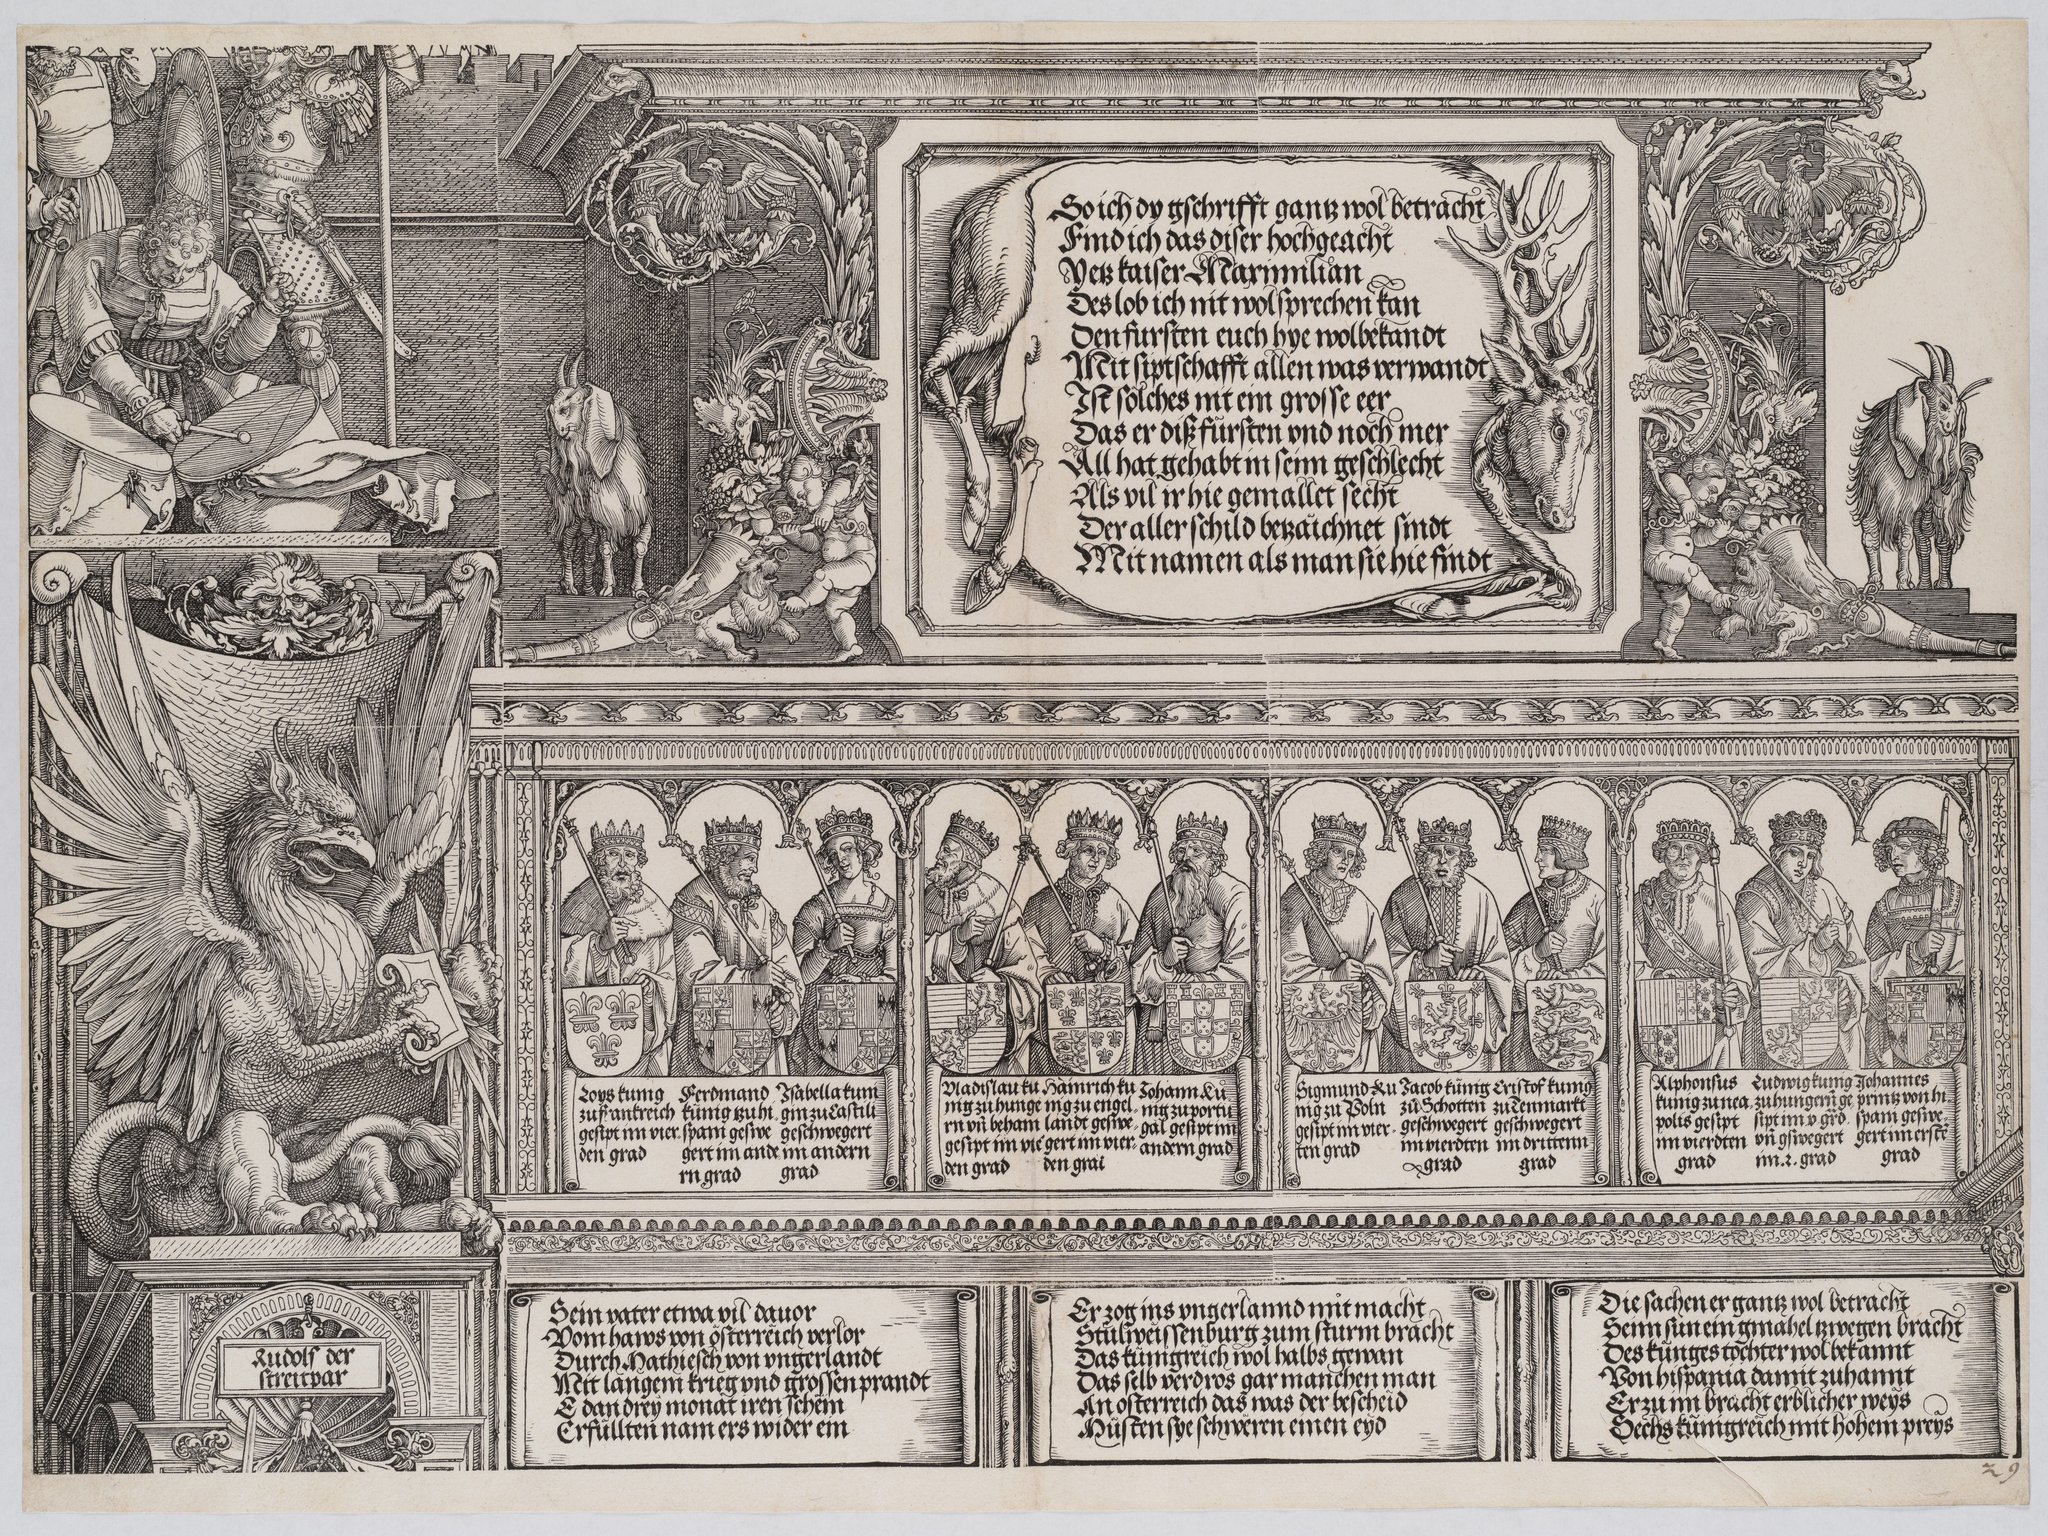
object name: print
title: The Upper Section of the Right Portal, with the Inscription on a Stag Skin; a Frieze with Busts of Roman Emperors; and the Entablature of the Columns, from the Arch of Honor, proof, dated 1515, printed 1517-18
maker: albrecht dürer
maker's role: artist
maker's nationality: german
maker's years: 1471-1528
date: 1515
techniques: letterpress, woodcut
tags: emperors,griffins